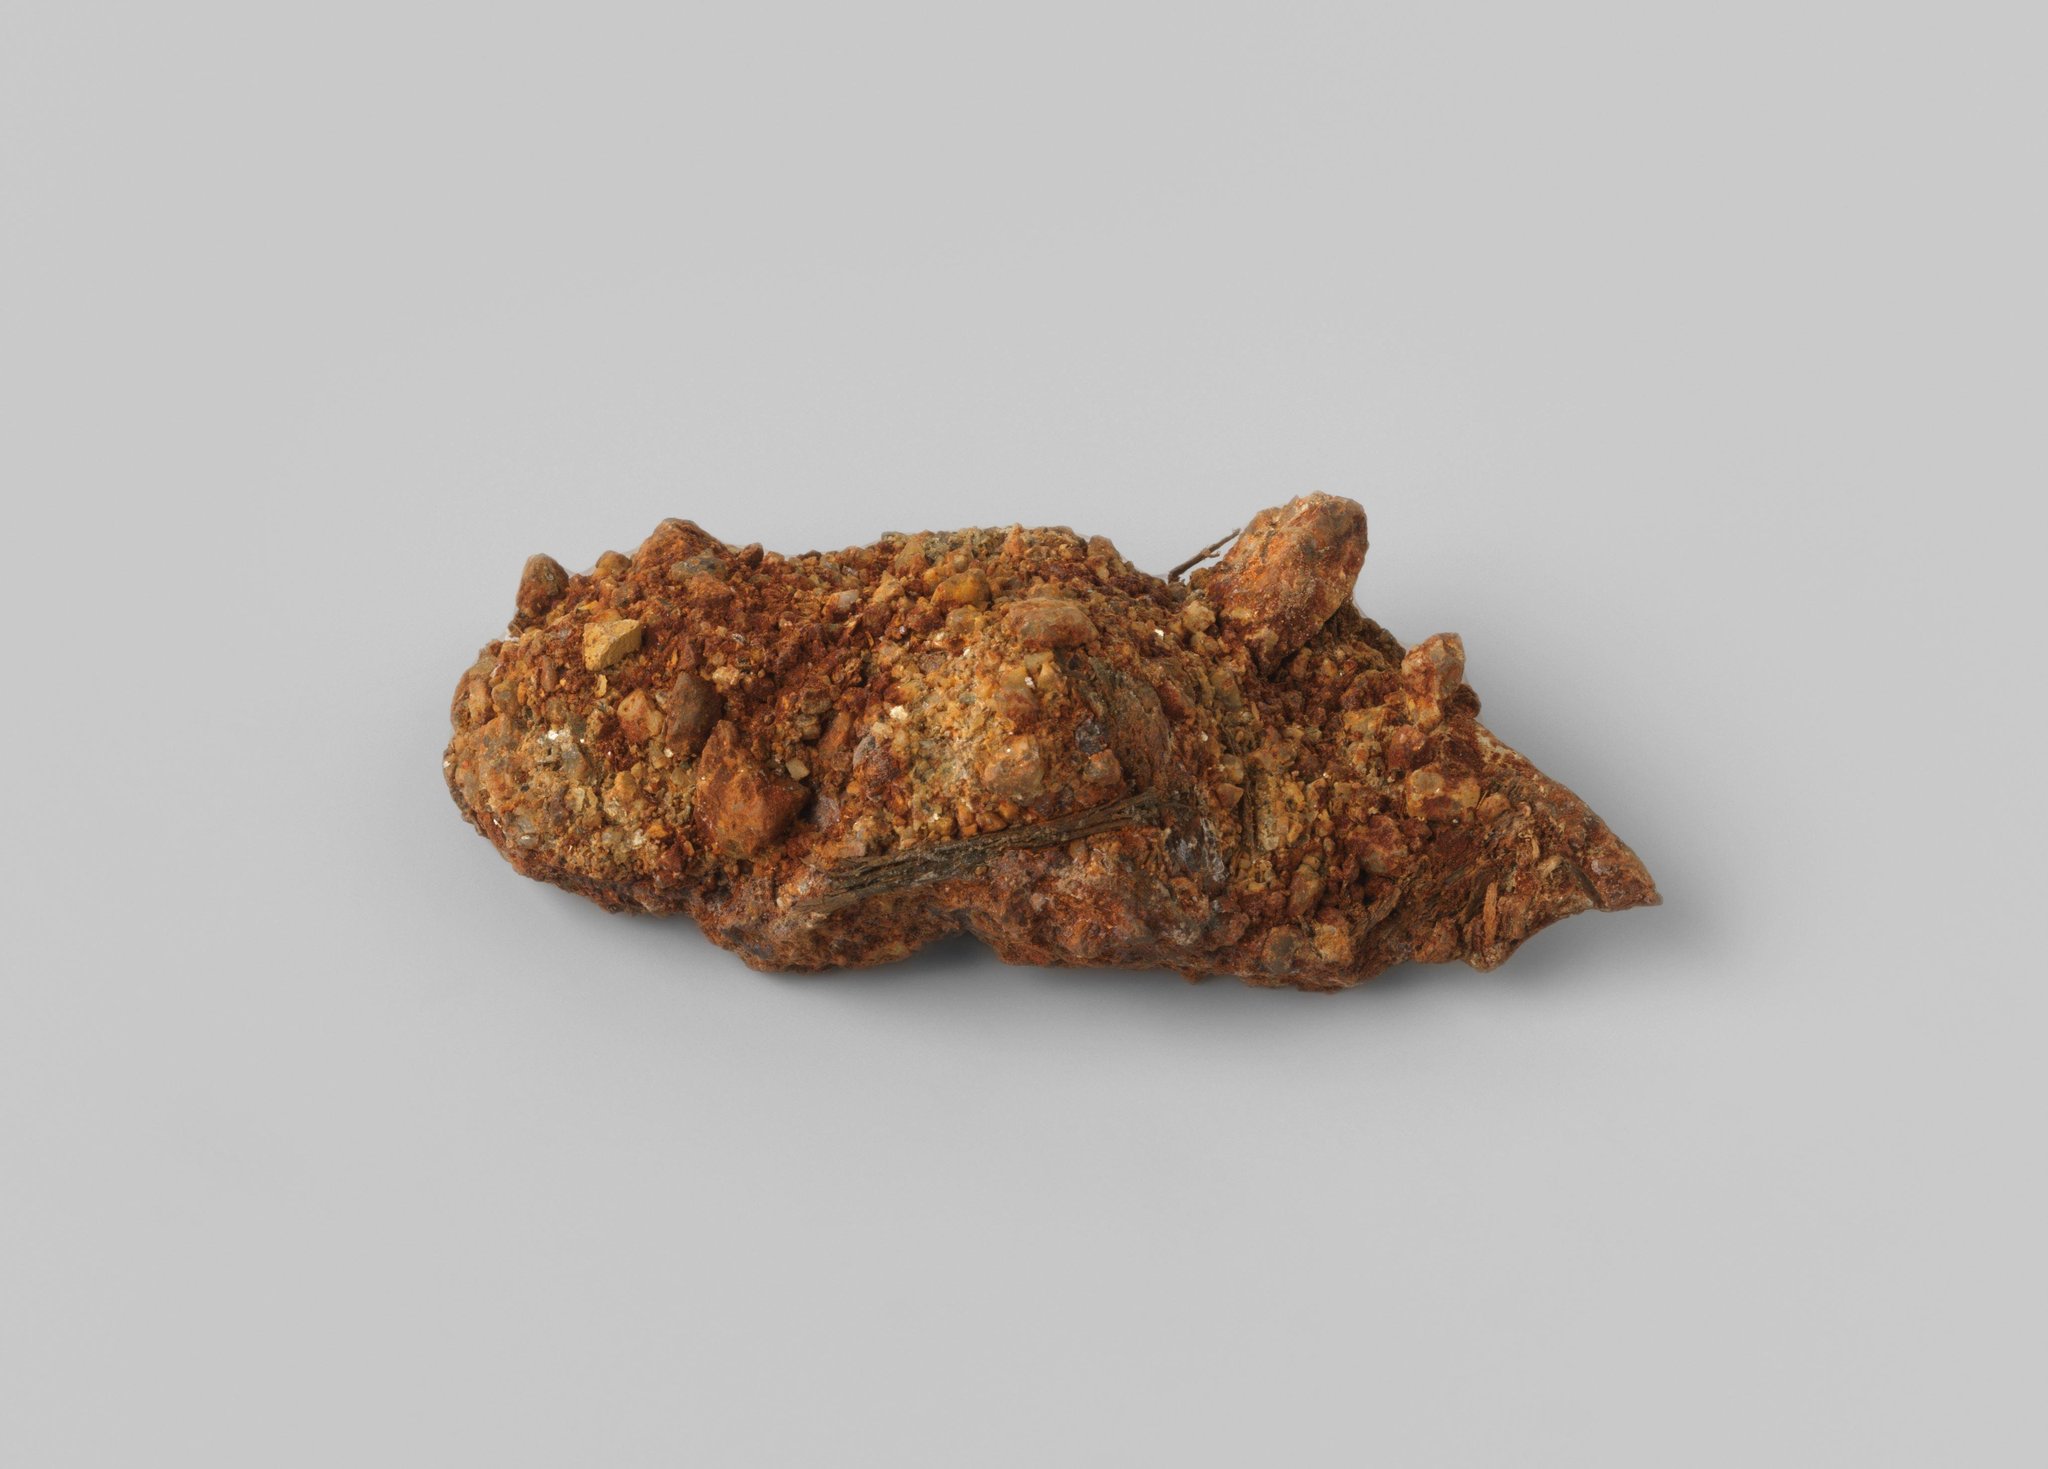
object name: trekkerplaat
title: Trekkerplaat in concretie van een musket uit het wrak van de Oost-Indiëvaarder Hollandia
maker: Anonymous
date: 1700-1743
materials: stone, copper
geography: netherlands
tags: verenigde oostindische compagnie, hollandia (schip), annet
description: Musket, trigger plate; id. NG 1980-27H2541, concreted.